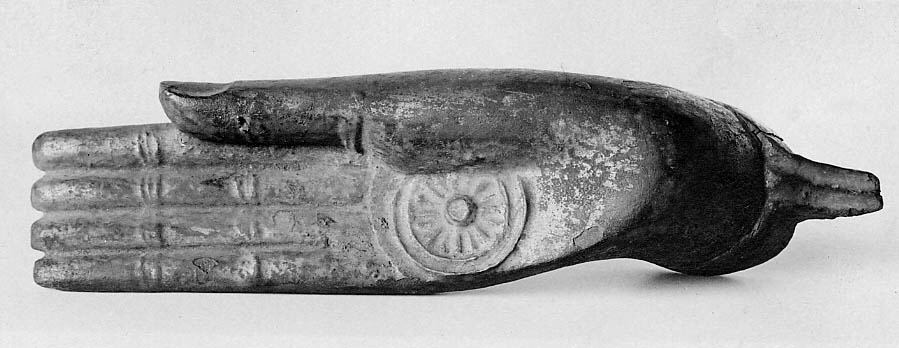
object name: hand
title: Hand of a Buddha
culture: cambodian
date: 1601-1700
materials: gilt, lacquer, wood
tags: hands,buddhism